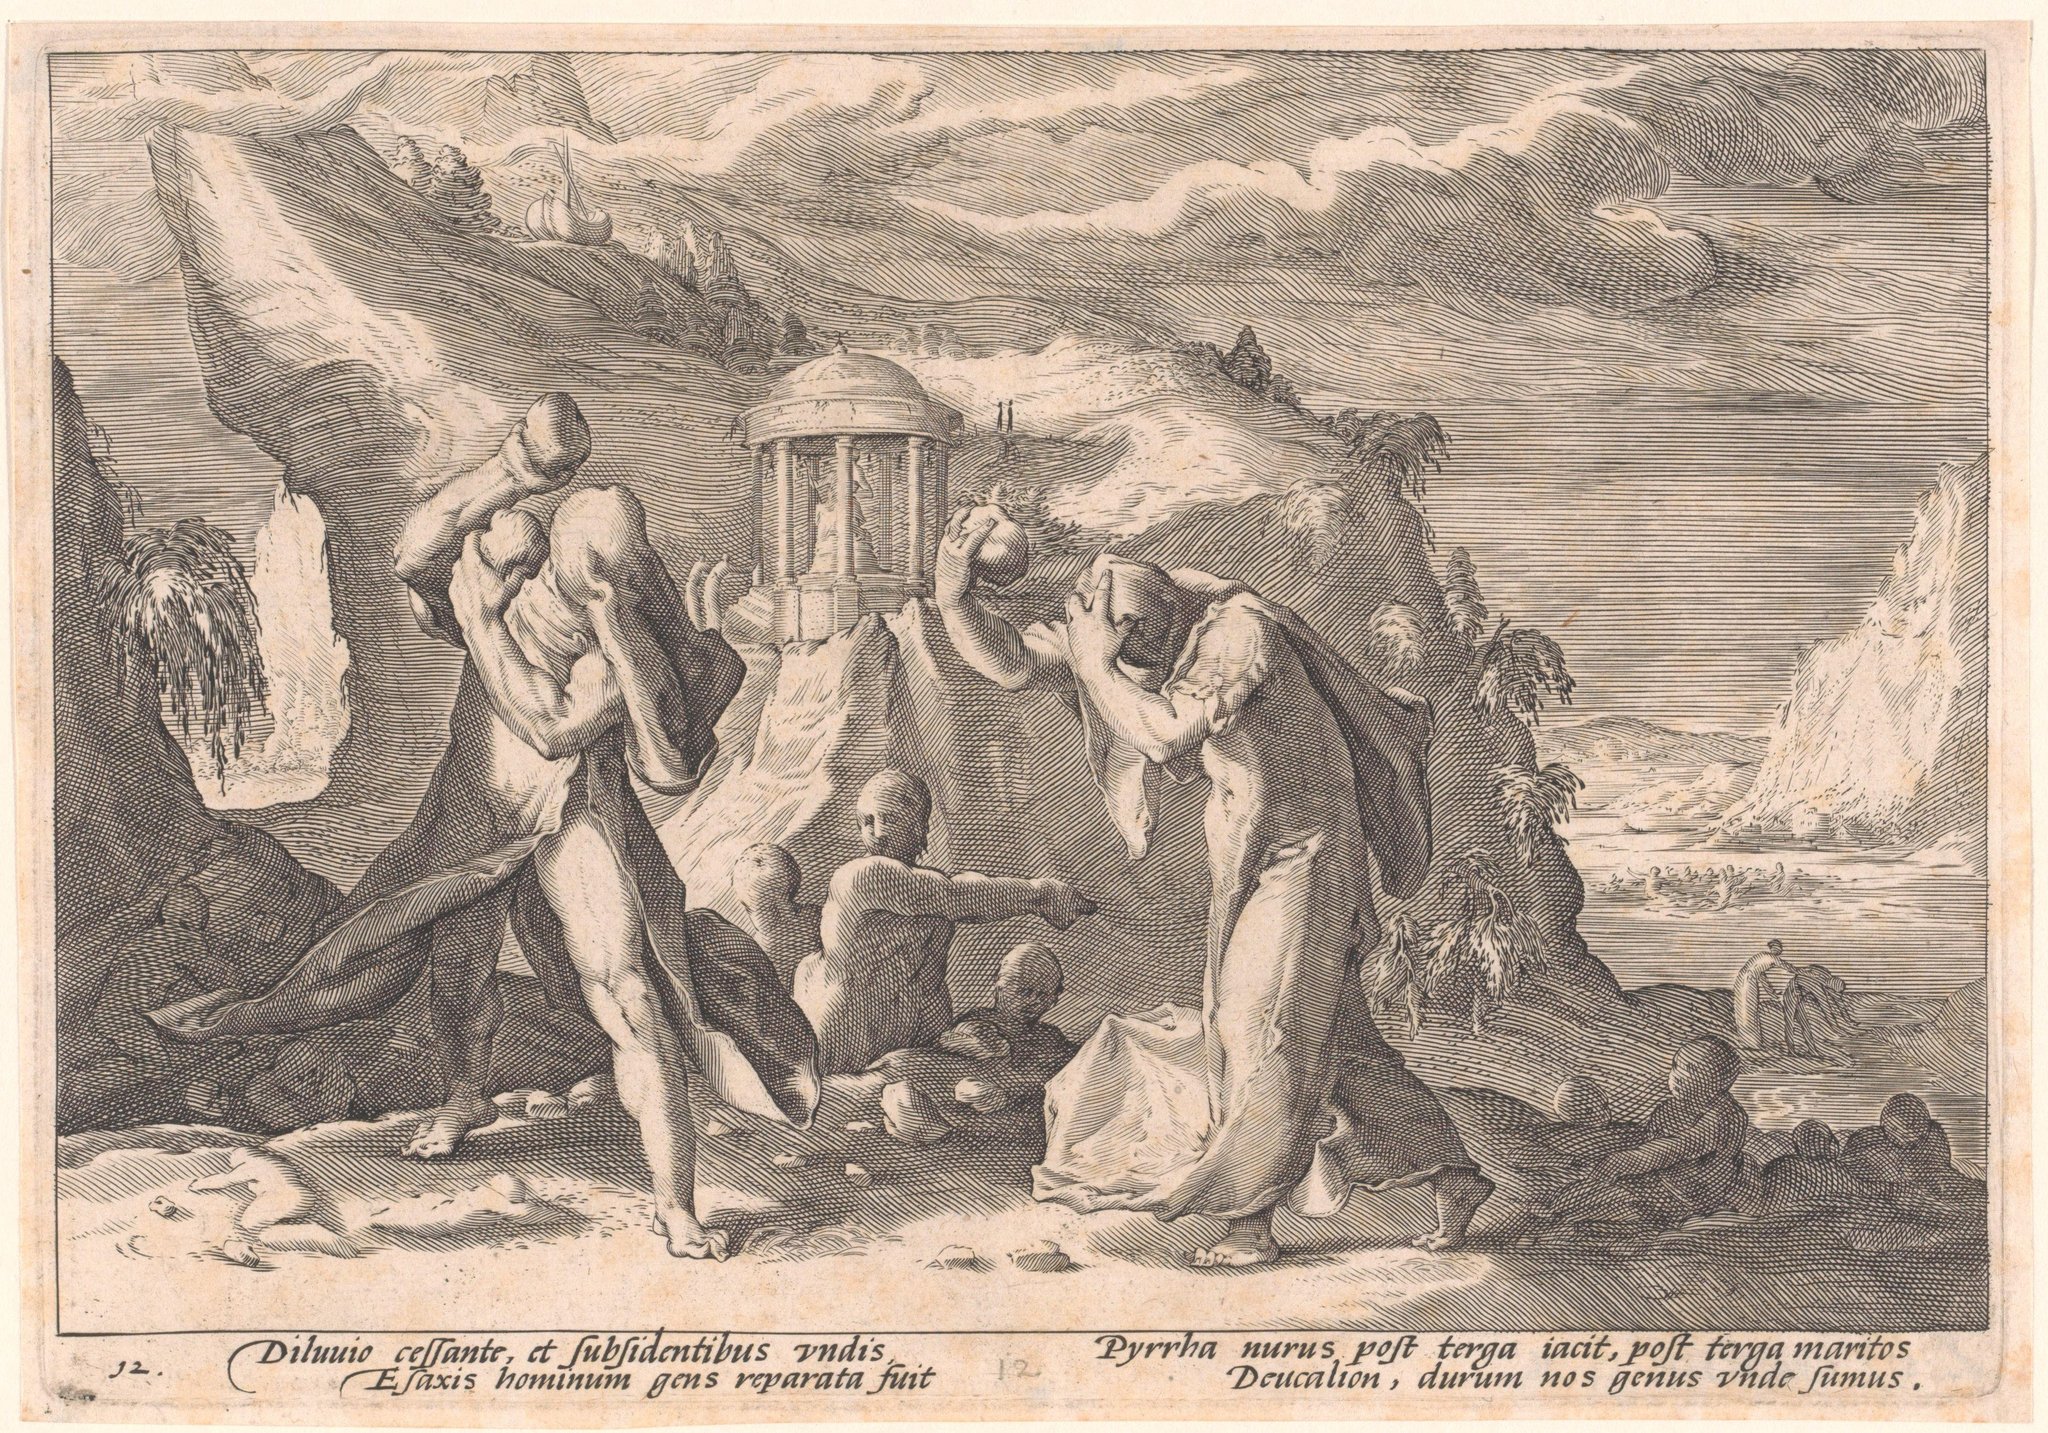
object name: print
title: Deucalion en Pyrrha scheppen een nieuw mensenras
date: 1589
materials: paper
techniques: engraving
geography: haarlem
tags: stones turning into men: stones thrown by deucalion and pyrrha, as directed by the oracle of themis, turn into men (ovid, metamorphoses x 400)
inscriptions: collector's mark: ‘Hinloopen’, collector's mark: Lugt 11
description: Deucalion en Pyrrha, de enige man en vrouw die de grote zondvloed van de goden overleefd hadden, werpen met bedekt gezicht stenen achter zich, die veranderen in mannen en vrouwen. Van het orakel in de tempel achter hen kregen zij deze raad. Links op de berg achter het orakel is de ark te zien waarin Deucalion en Pyrrha de zondvloed overleefden. In de ondermarge een vierregelige toelichting, in twee kolommen, in het Latijn.